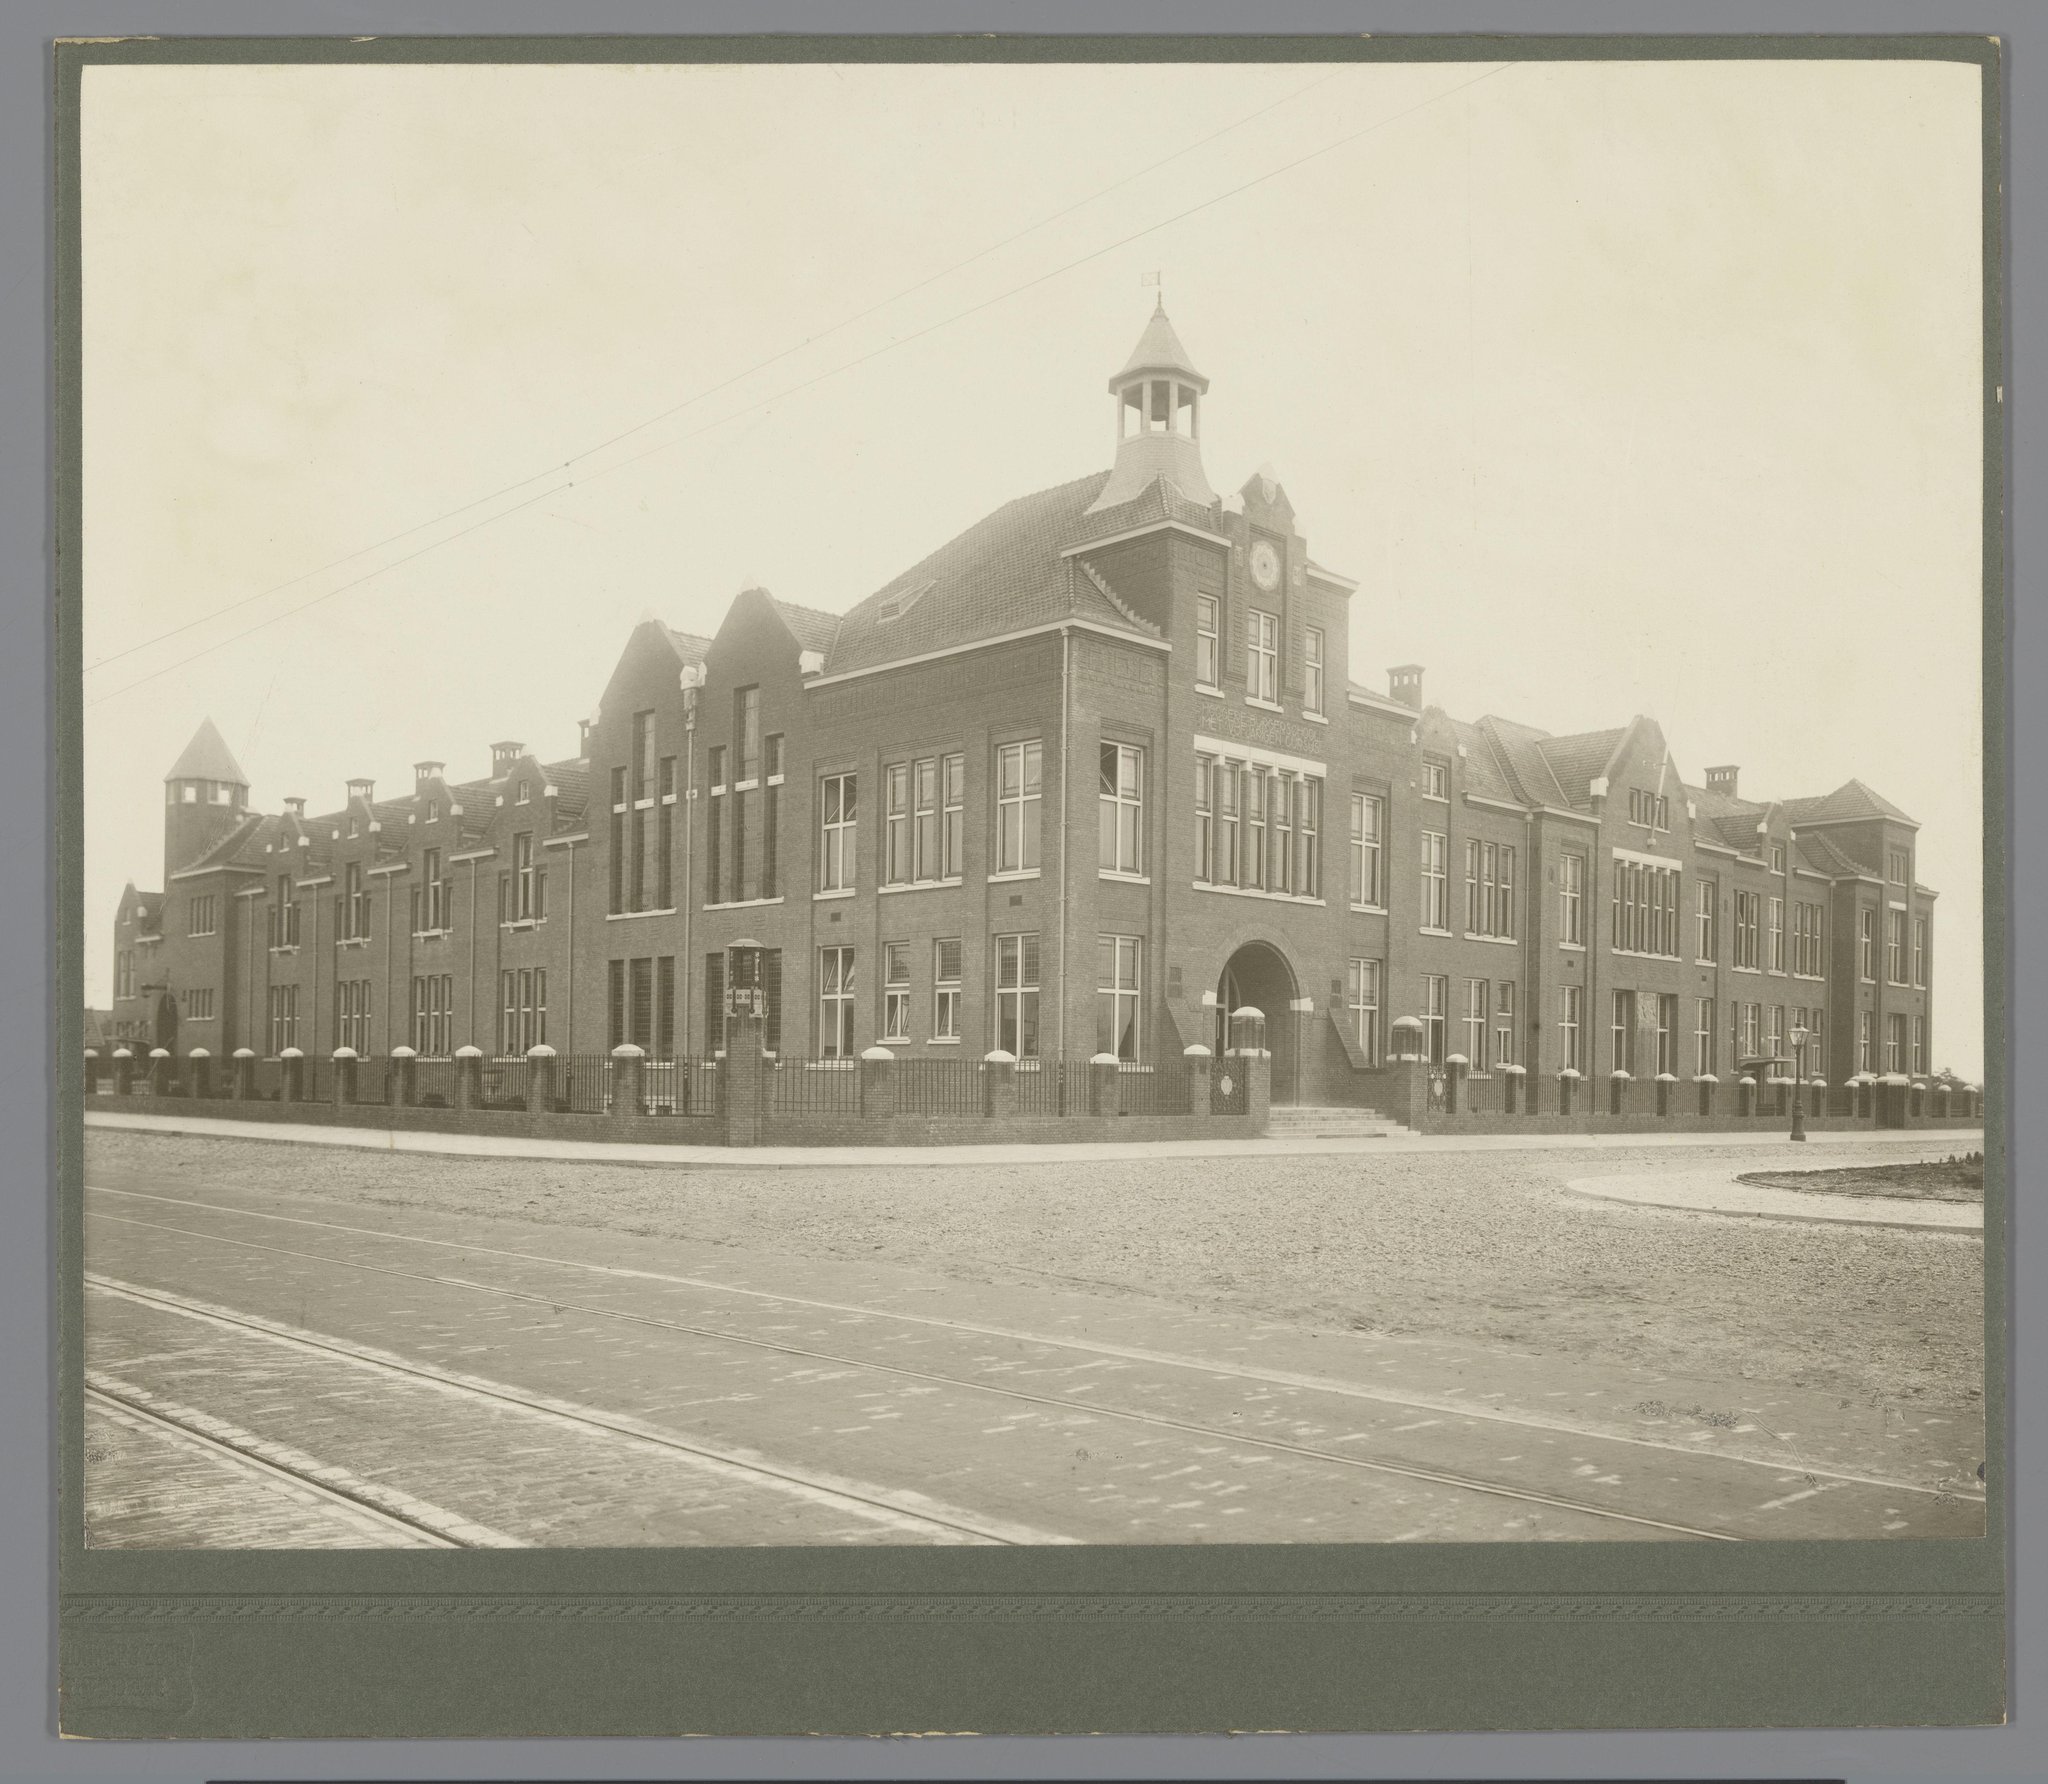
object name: photograph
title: Gezicht op de Hoogere Burgerschool te Leiden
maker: Anonymous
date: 1915-1930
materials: cardboard, photographic support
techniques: collodion silver print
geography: leiden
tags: secondary education, leiden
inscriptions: annotation: ‘R.H.B.S./ Leiden/ (oostkant)’, annotation: ‘Foto J. Jonker en Zonen’